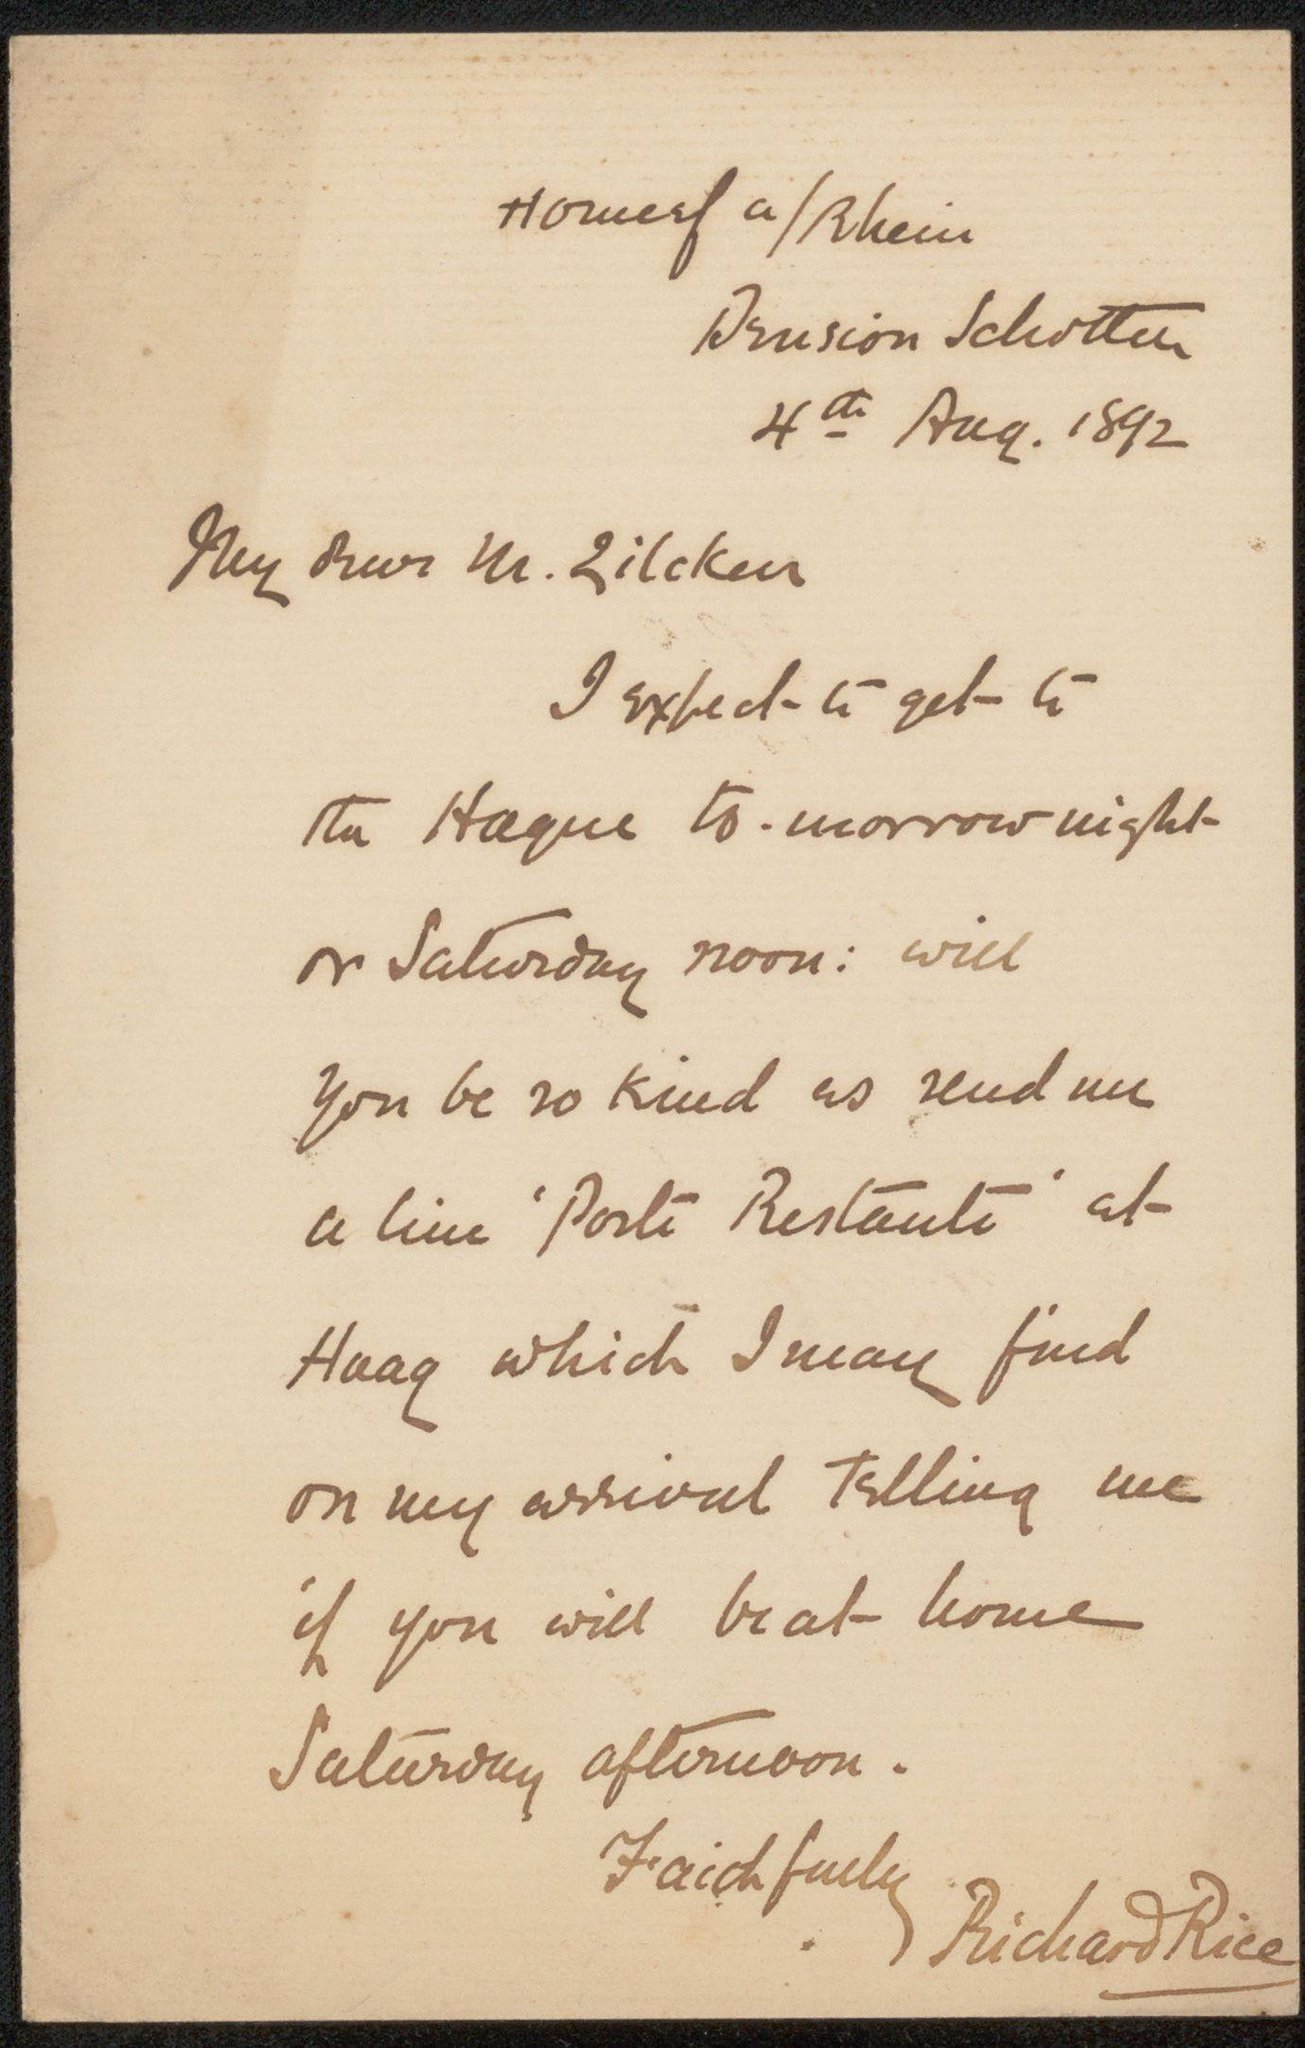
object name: letter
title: Brief aan Philip Zilcken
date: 1892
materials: ink, paper, pencil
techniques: pen, writing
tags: the hague, painter, draughtsman, philip zilcken